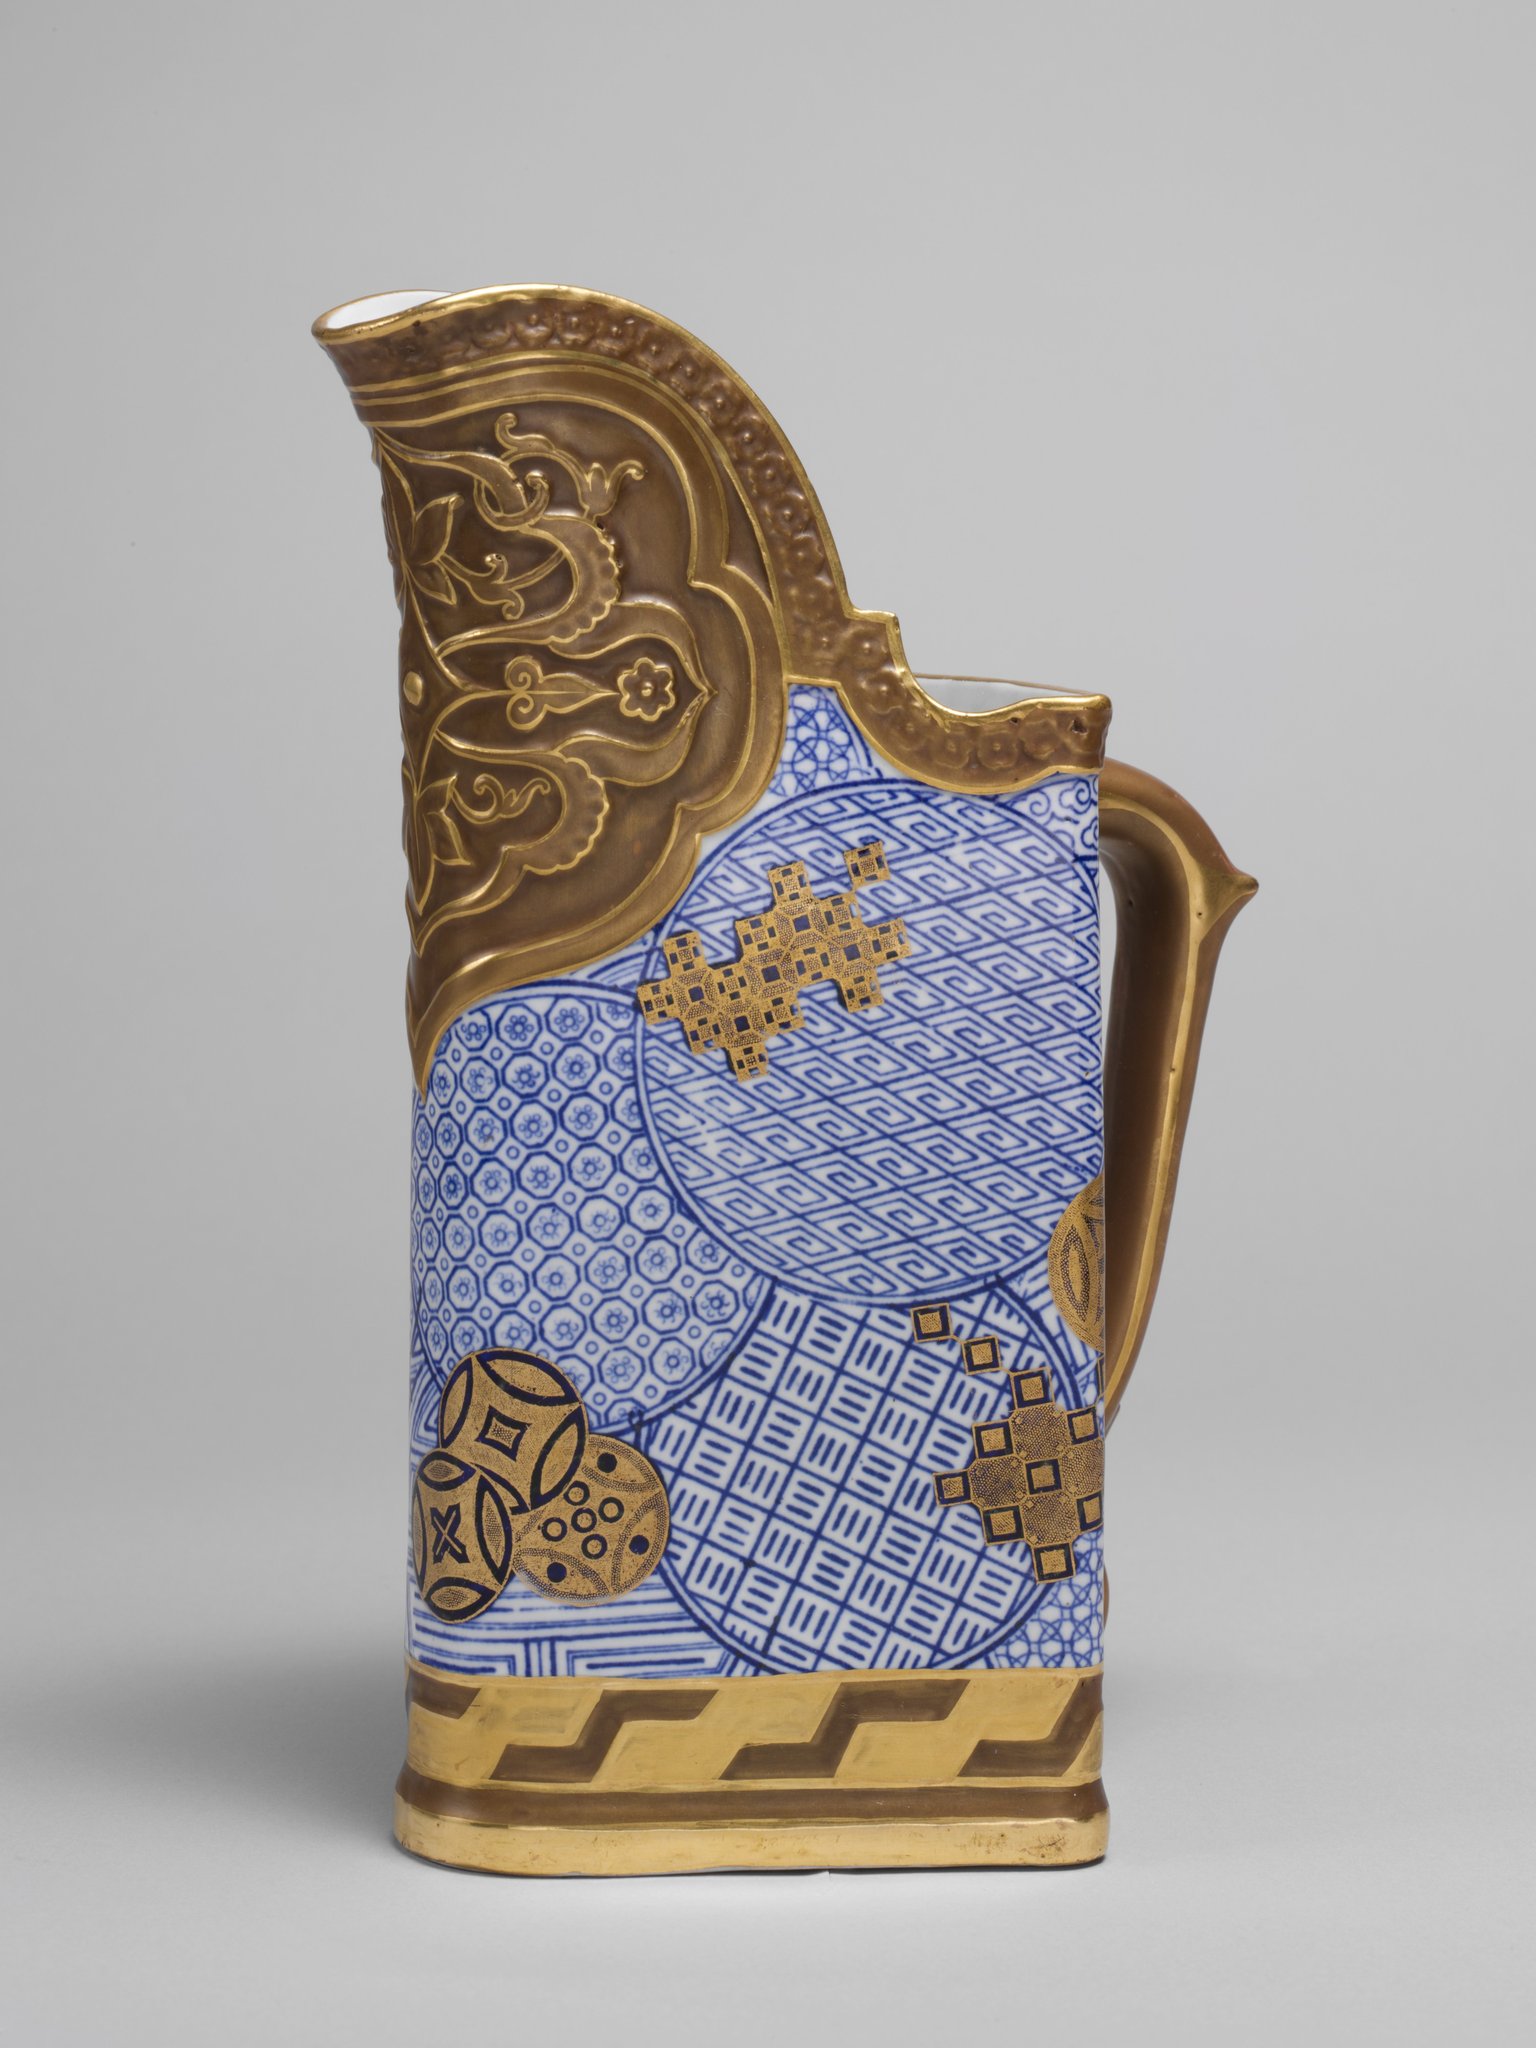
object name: pitcher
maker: worcester factory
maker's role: factory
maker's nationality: british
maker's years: 1751-2008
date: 1880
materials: bone china